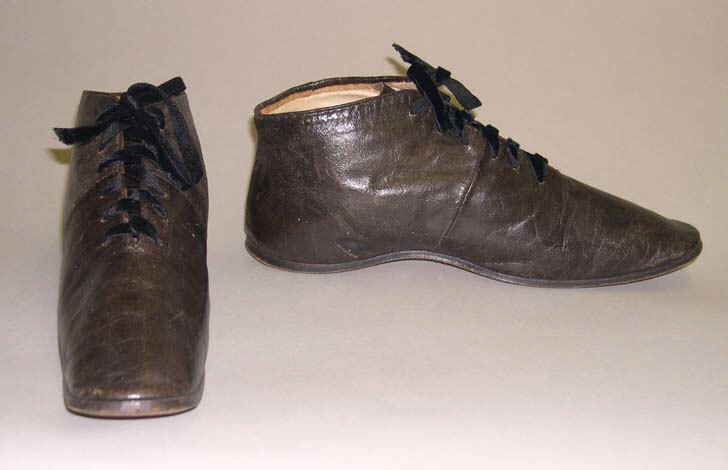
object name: shoe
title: Shoes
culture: american or european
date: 1800-1850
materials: leather